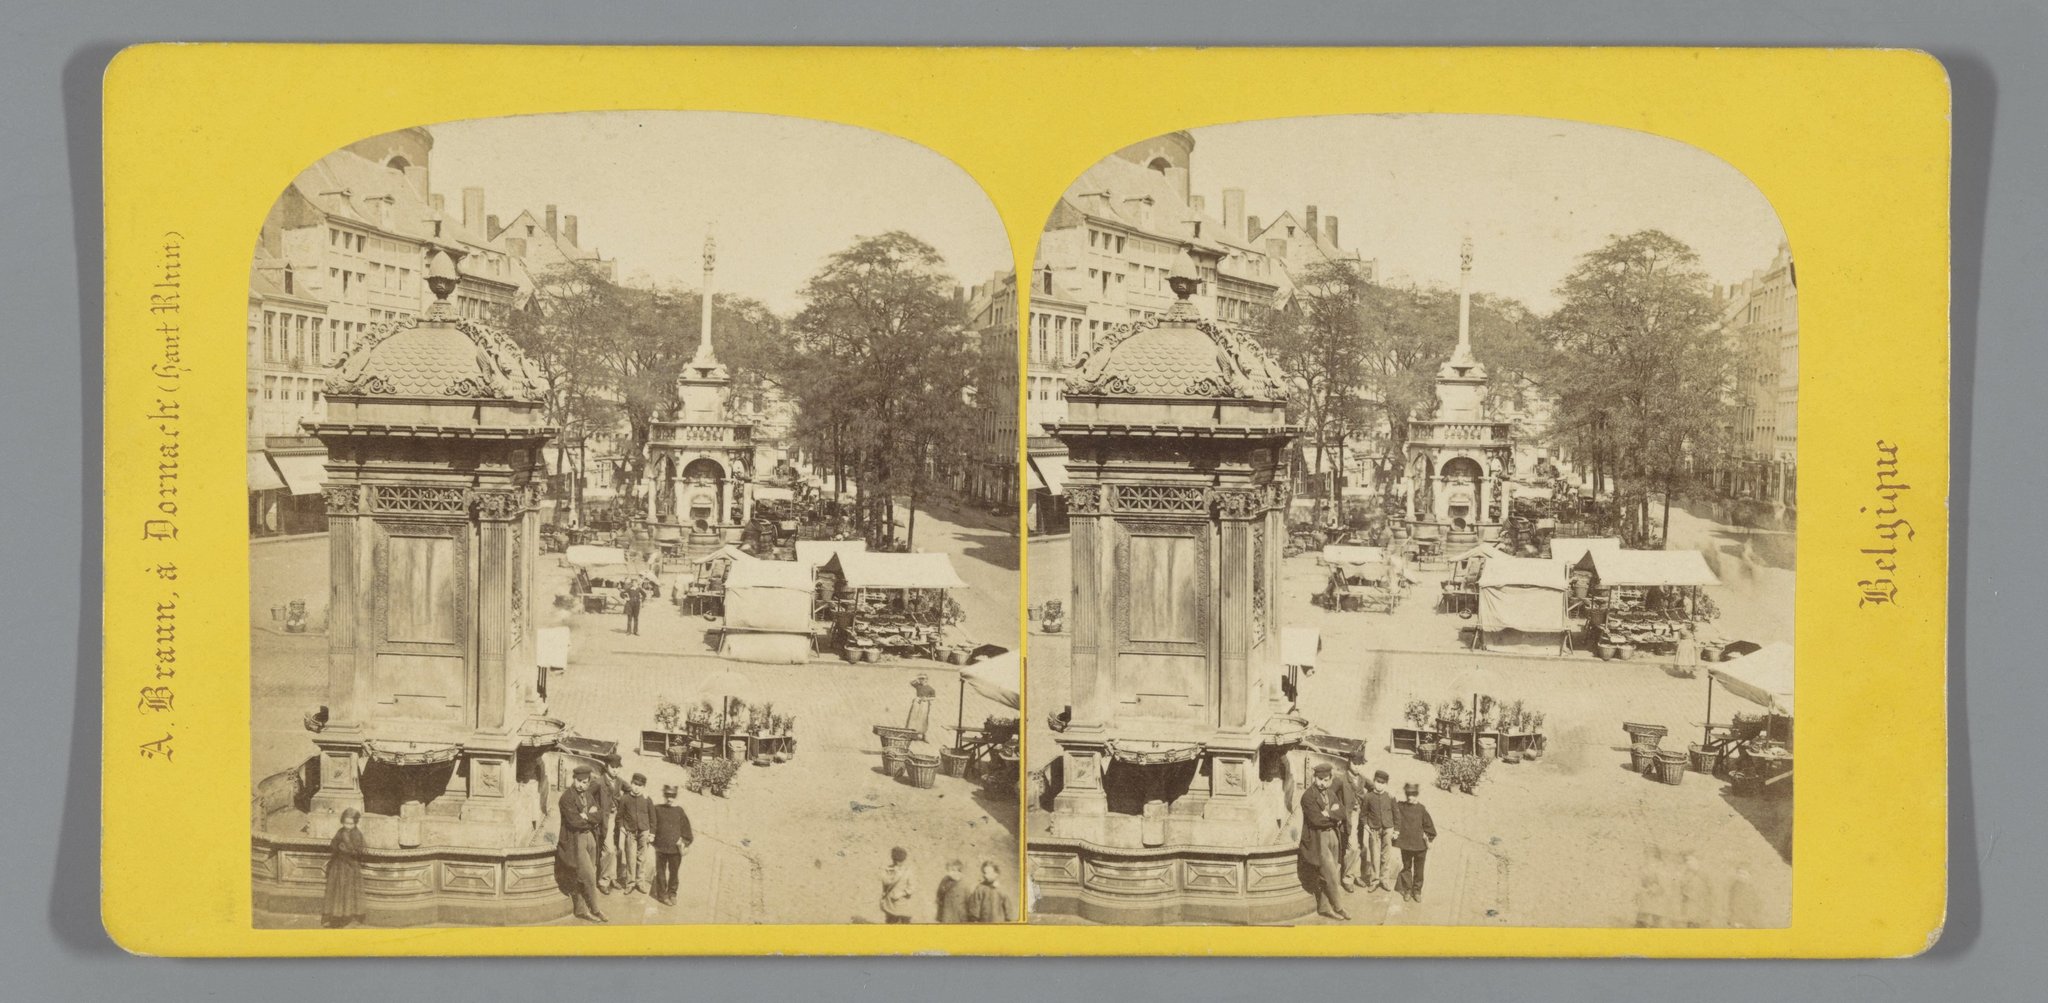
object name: stereograph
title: Place du Péron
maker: Anonymous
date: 1879-1889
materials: cardboard, paper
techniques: albumen print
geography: dornach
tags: square, place, circus, etc., liège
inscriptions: number: ‘No 4192.’